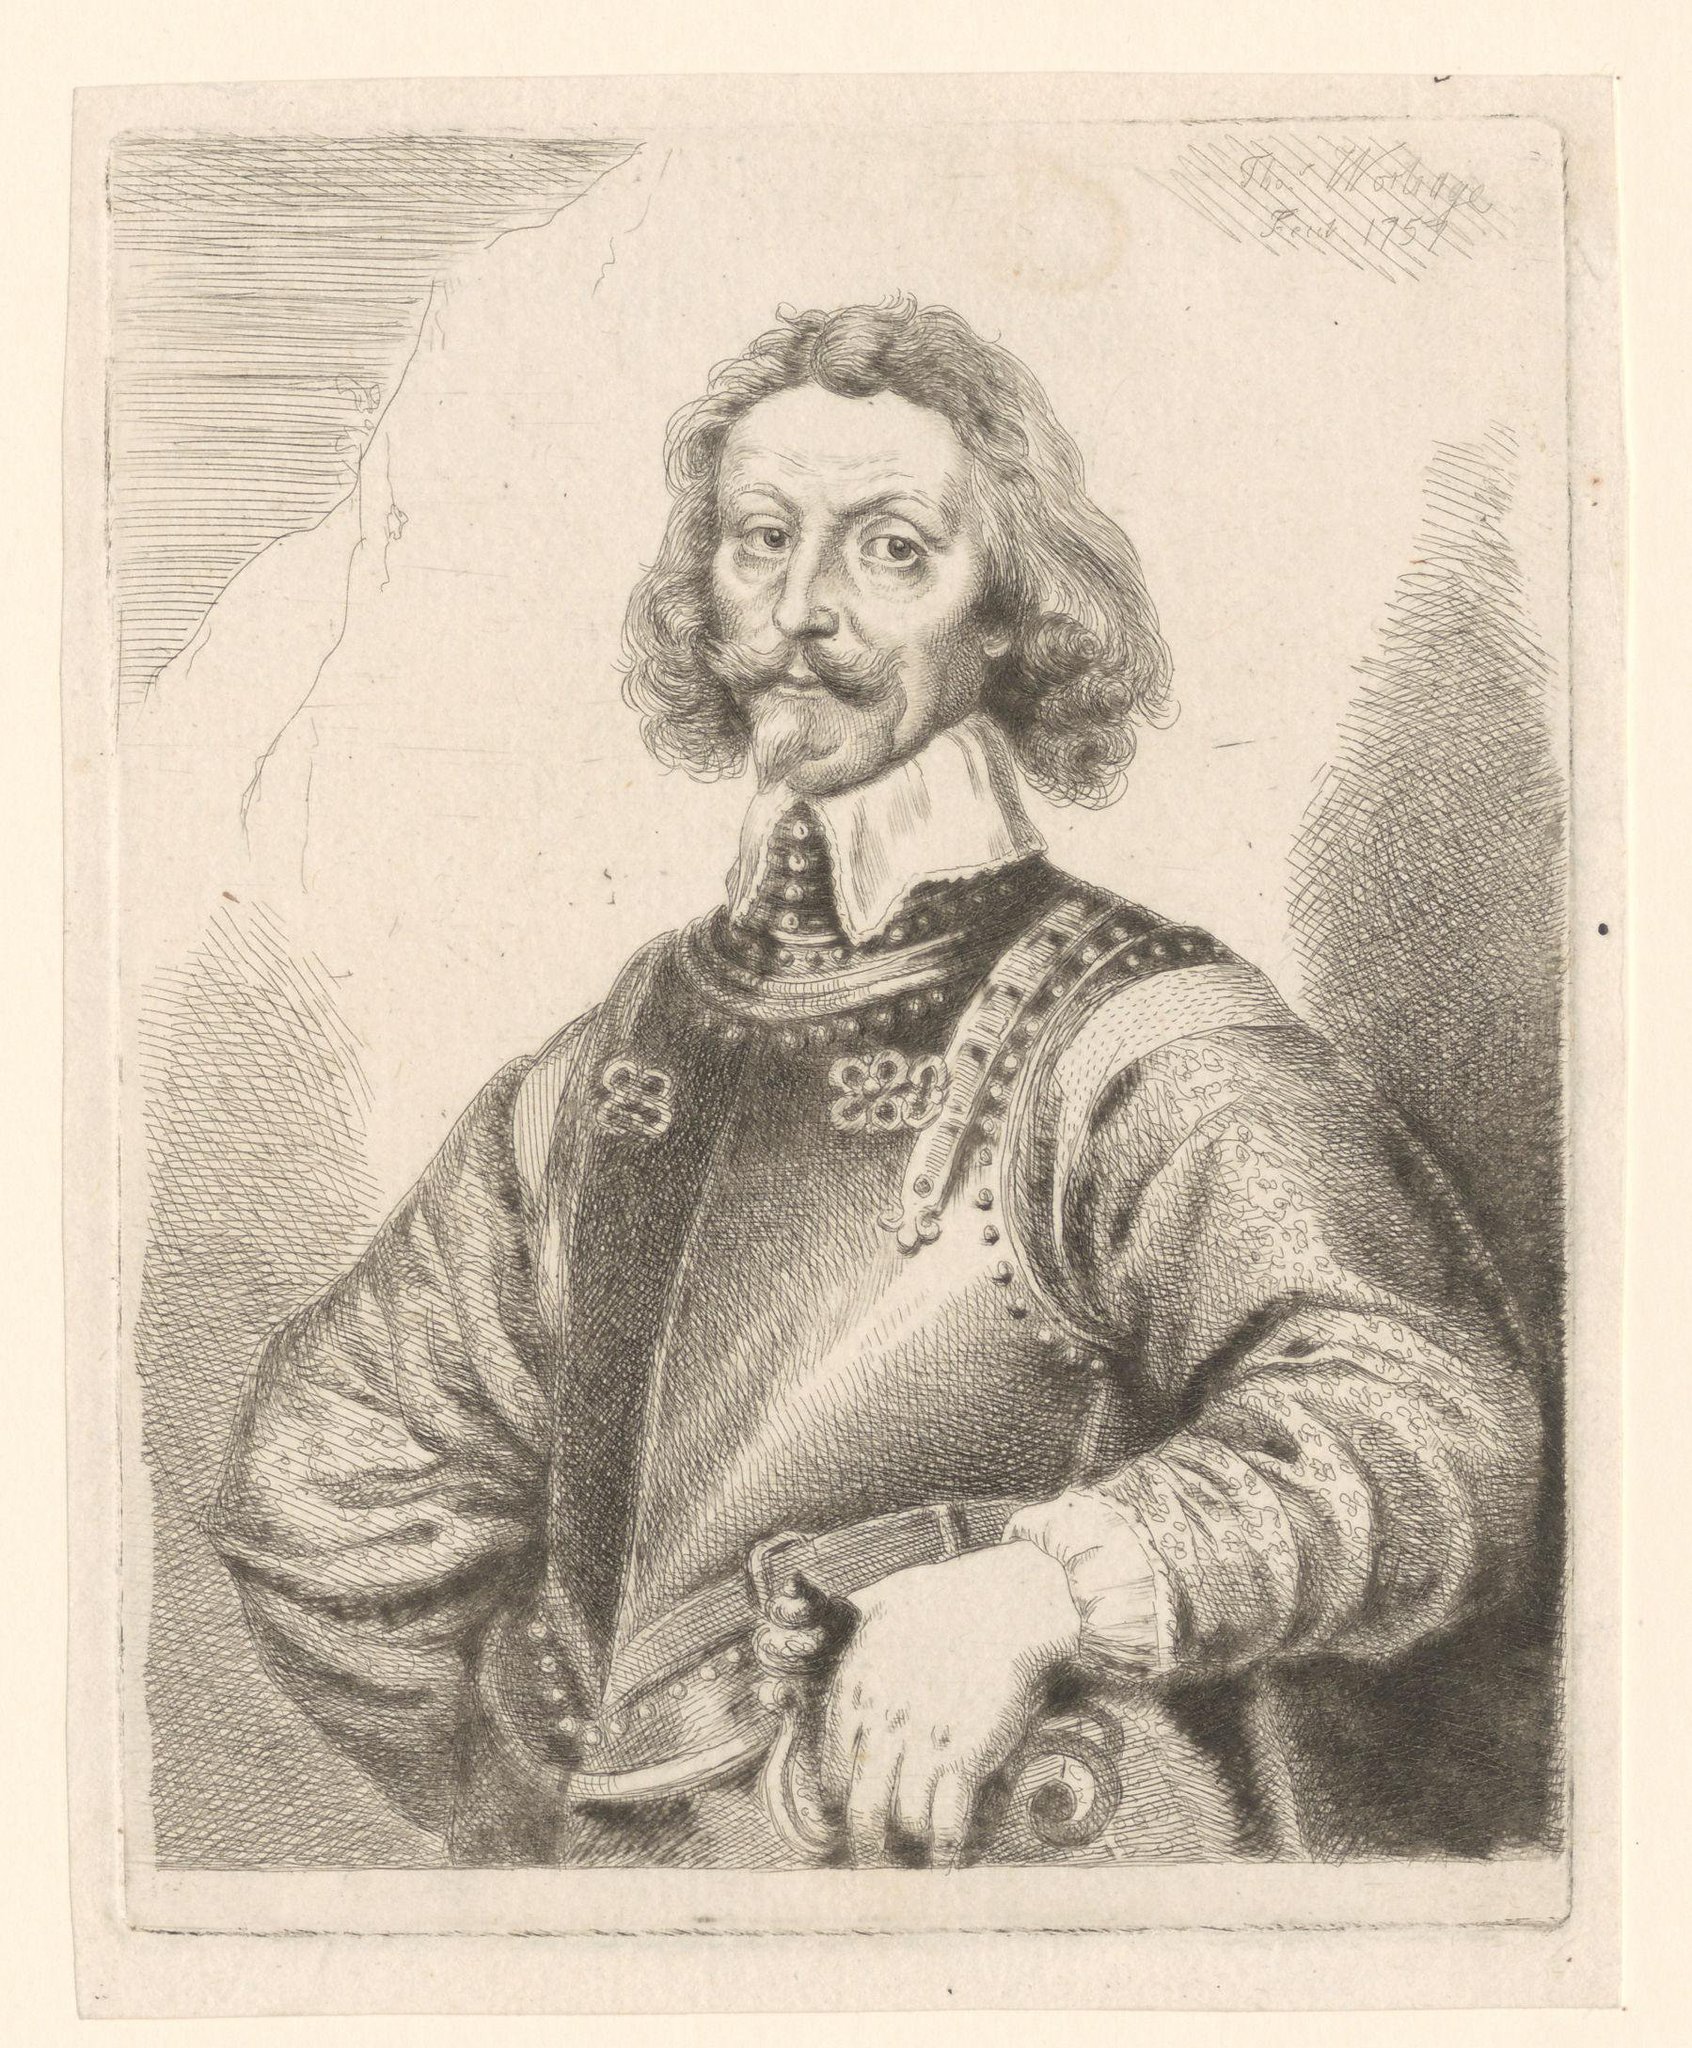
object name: print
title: Portret van Jacob Astley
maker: thomas worlidge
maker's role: print maker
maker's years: 1700-1766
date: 1757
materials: paper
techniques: drypoint, etching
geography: london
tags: historical person (...) - historical person (...) portrayed alone, commander-in-chief, general, marshal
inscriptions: collector's mark: Lugt 2760, collector's mark: Lugt 2228